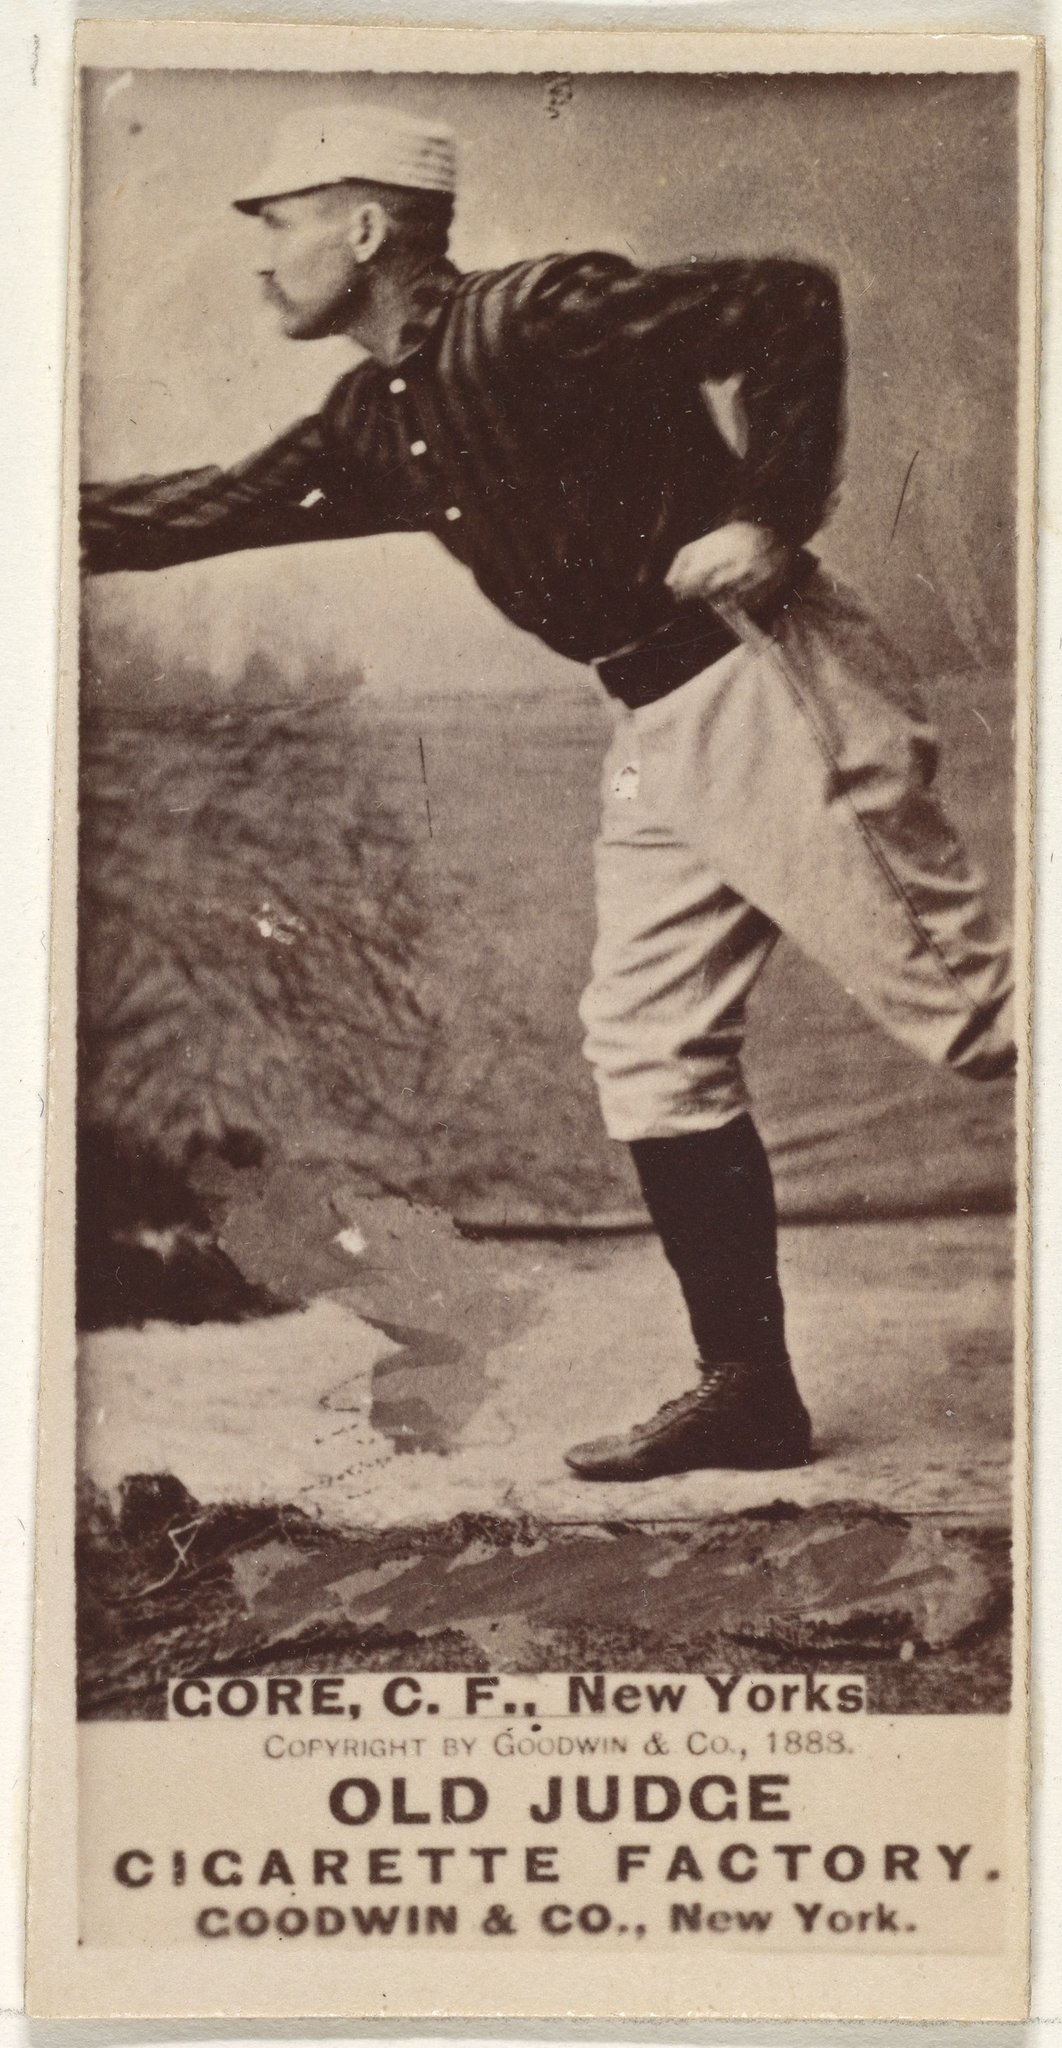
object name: baseball card, photograph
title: George F. "Piano Legs" Gore, Center Field, New York, from the Old Judge series (N172) for Old Judge Cigarettes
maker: goodwin & company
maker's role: publisher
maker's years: 1850-1950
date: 1888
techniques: albumen silver print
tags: men,portraits,baseball,athletes